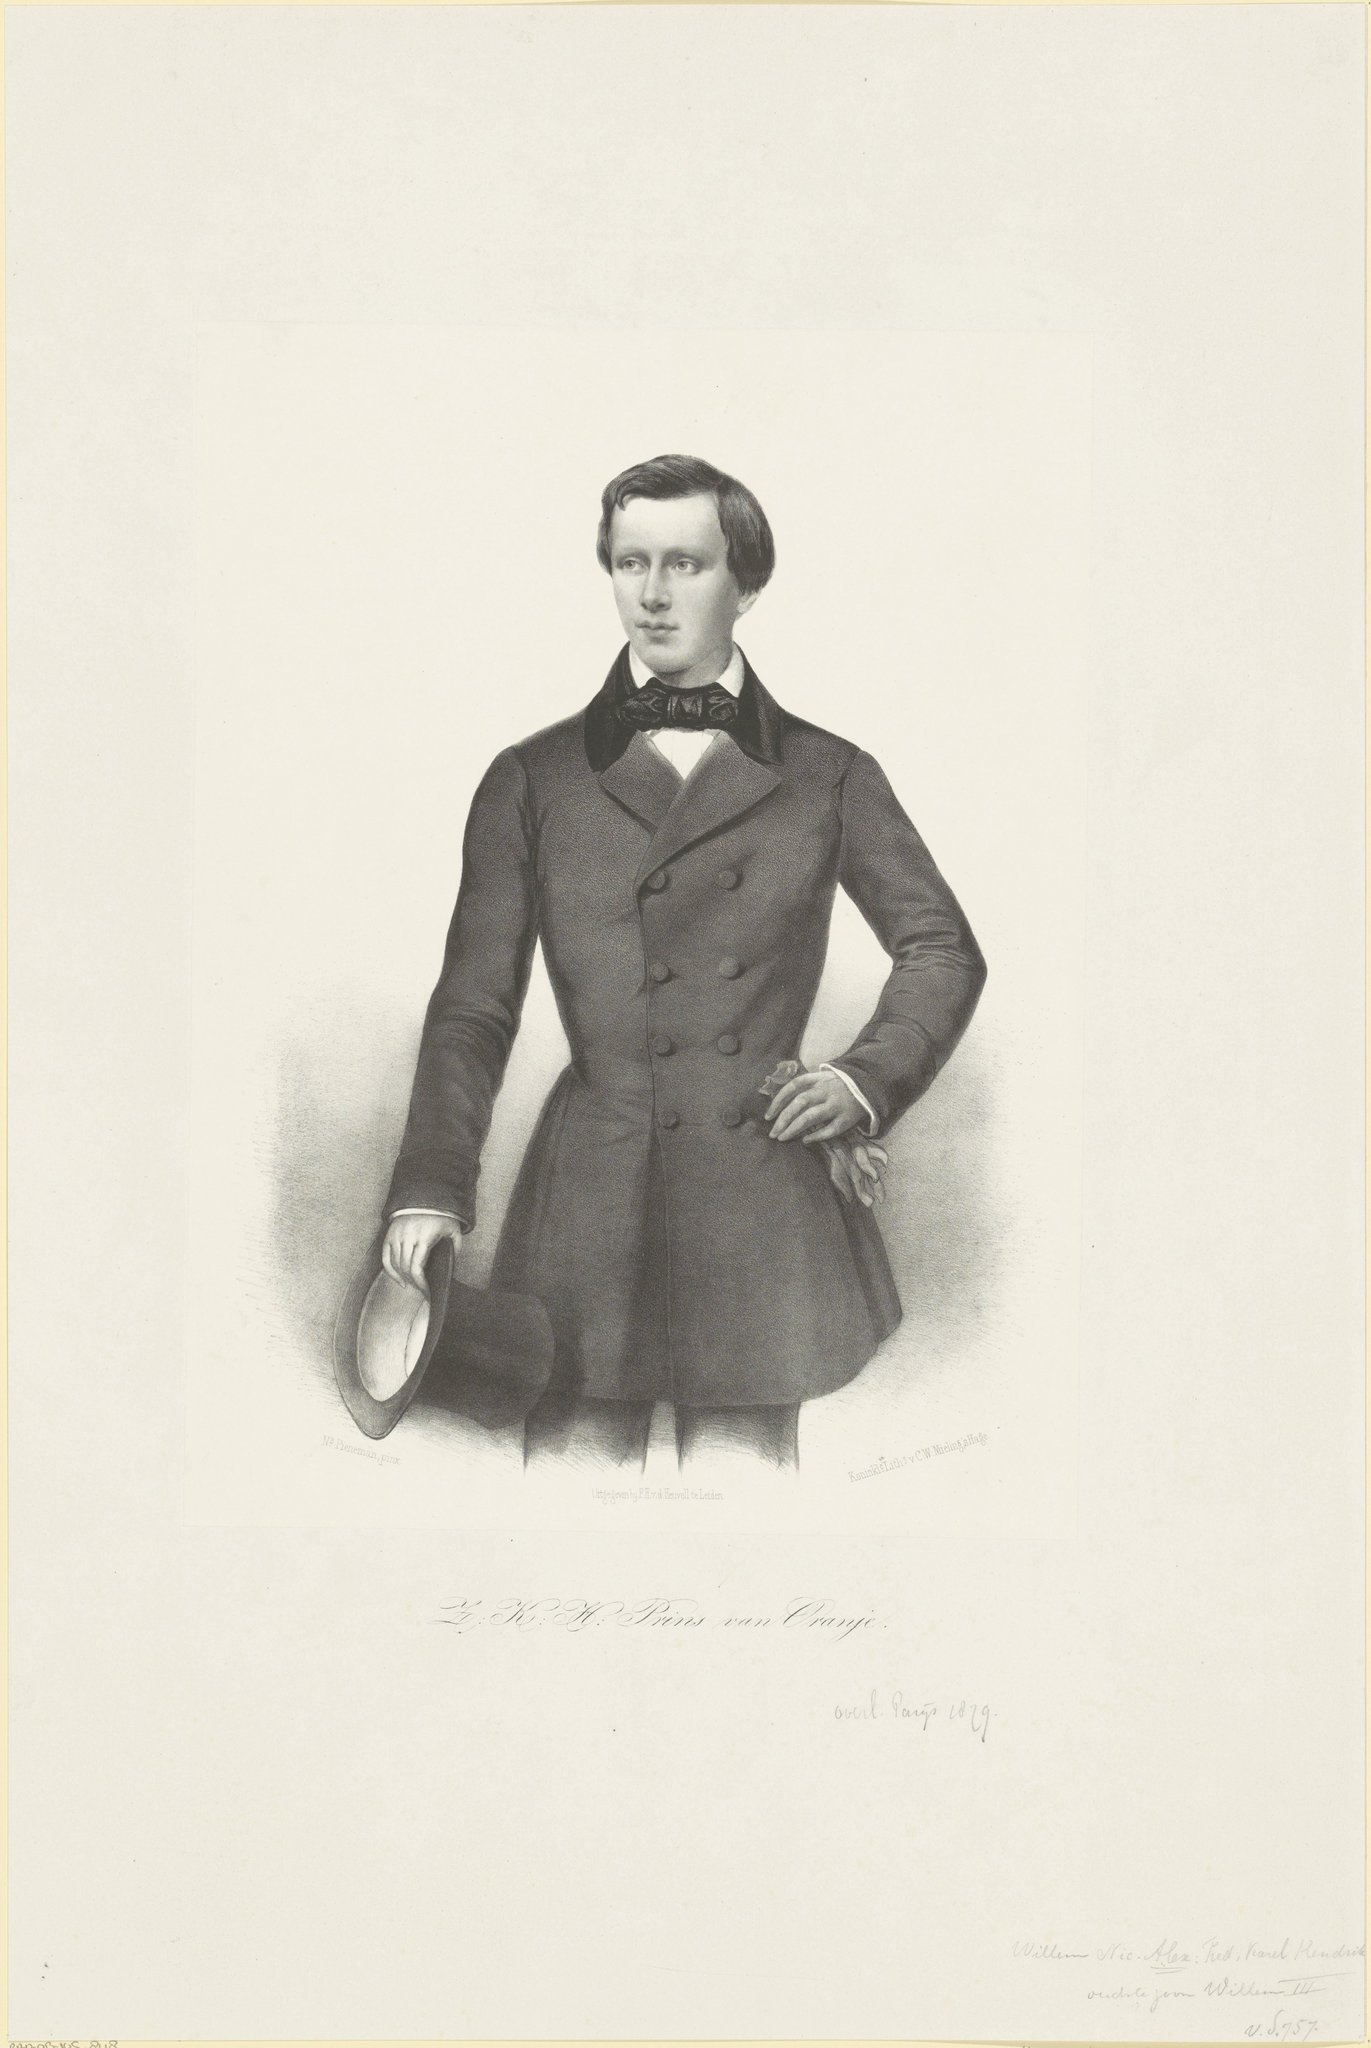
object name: print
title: Portret van Willem, prins der Nederlanden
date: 1858-1871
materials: paper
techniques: lithograph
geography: netherlands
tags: the hague, paris, willem (prins der nederlanden)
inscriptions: collector's mark: Lugt 963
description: De hier vermelde titel verwijst naar de hoogst verkregen titel van de geportretteerde, niet per se naar de titel die de geportretteerde op deze voorstelling draagt.